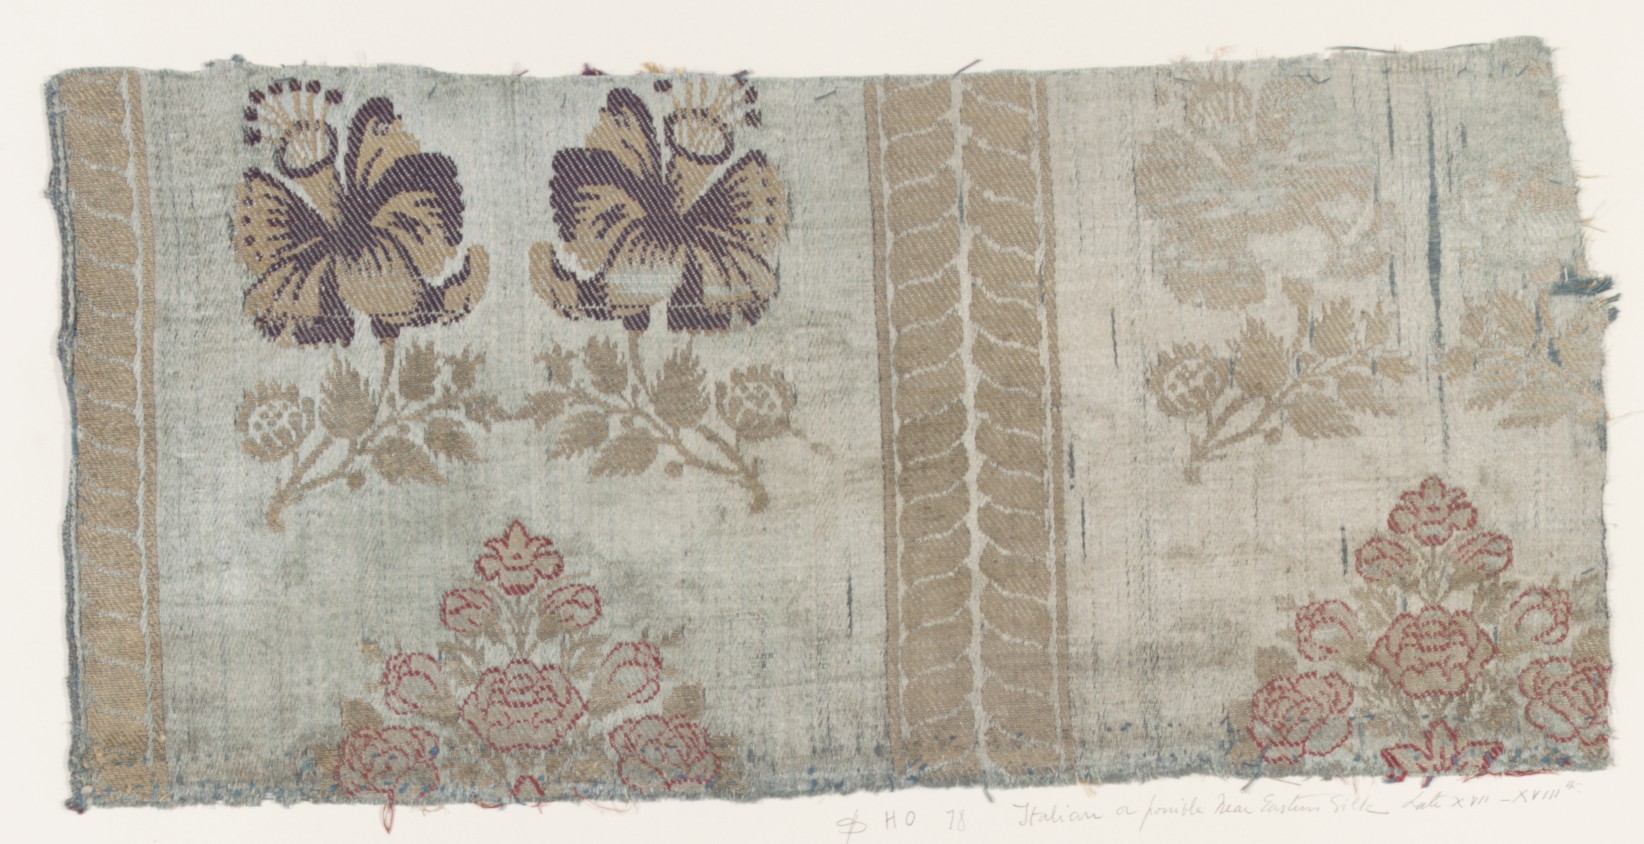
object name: fragment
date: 1601-1800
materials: silk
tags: flowers,leaves